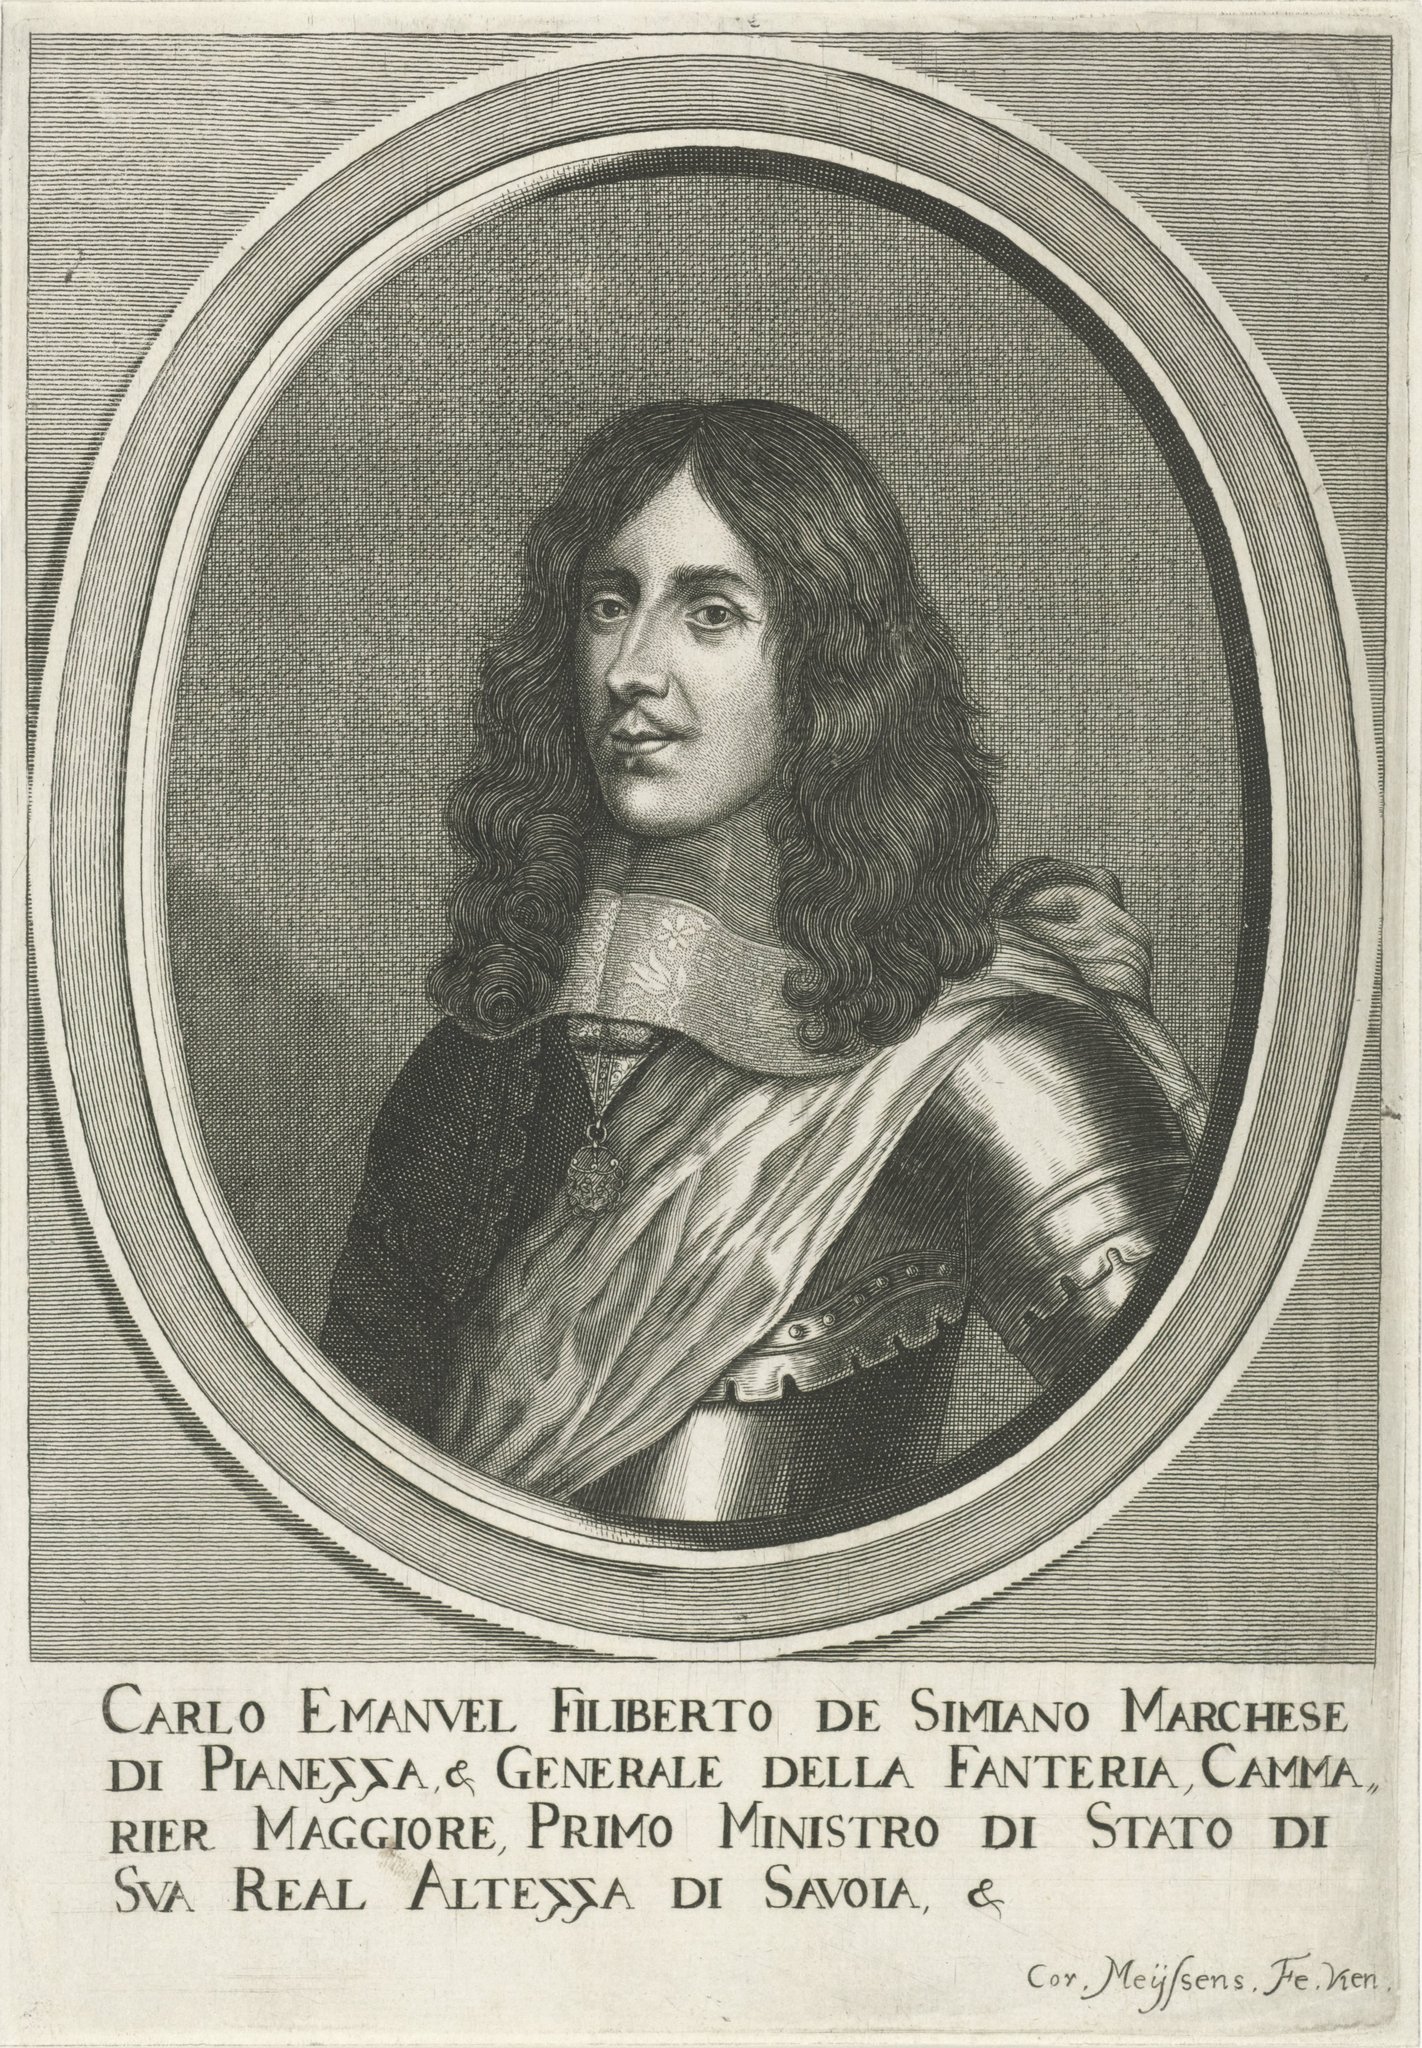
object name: print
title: Portret van Carlo Emanuele Filiberto de Simiana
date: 1670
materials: paper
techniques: engraving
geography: vienna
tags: carlo emanuele filiberto de simiana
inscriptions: collector's mark: Lugt 2228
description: Prent gebruikt in: Gualdo Priorato, Galeazzo. Historia di Leopoldo Cesare, (...). 3 dln. Wenen, Giovanni Battista Hacque, 1670-1674, dl. 1.